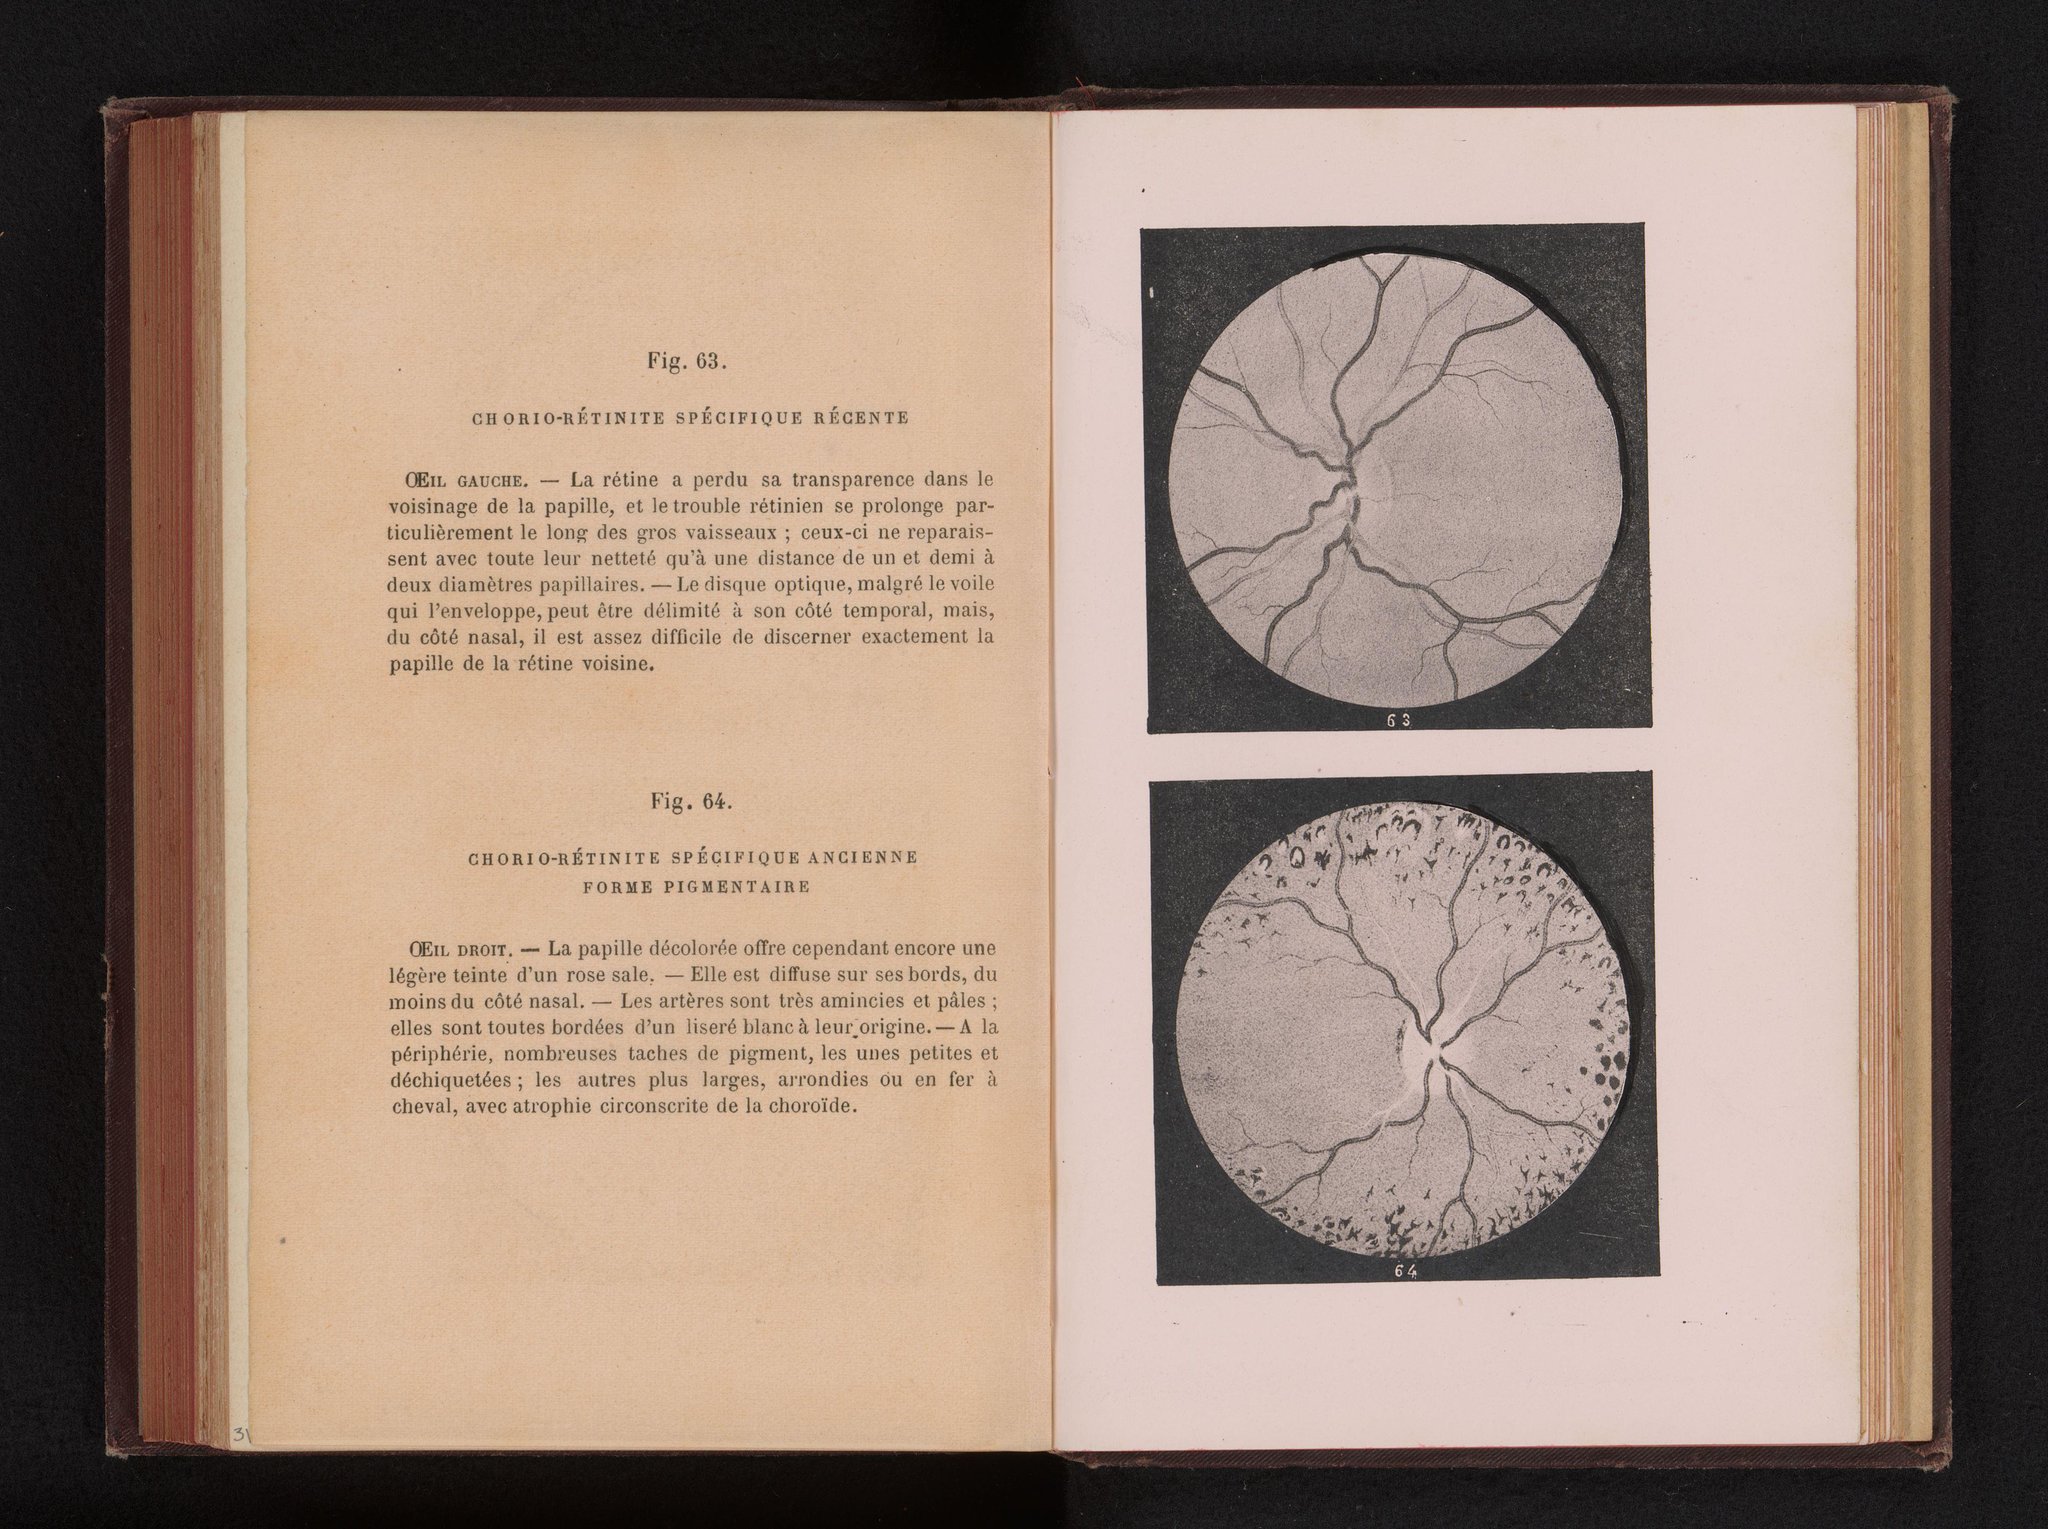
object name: photomechanical print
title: Fotoreproductie van twee anatomische tekeningen van een ontsteking aan het vaatvlies in een oog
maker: Anonymous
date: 1871-1891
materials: paper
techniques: photograph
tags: anatomy (non-medical), eyes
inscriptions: inscription: ‘Fig. 63. Chorio-rétinite spécifique récente Fig. 64. Chorio-rétinite spécifique ancienne forme pigmentaire’